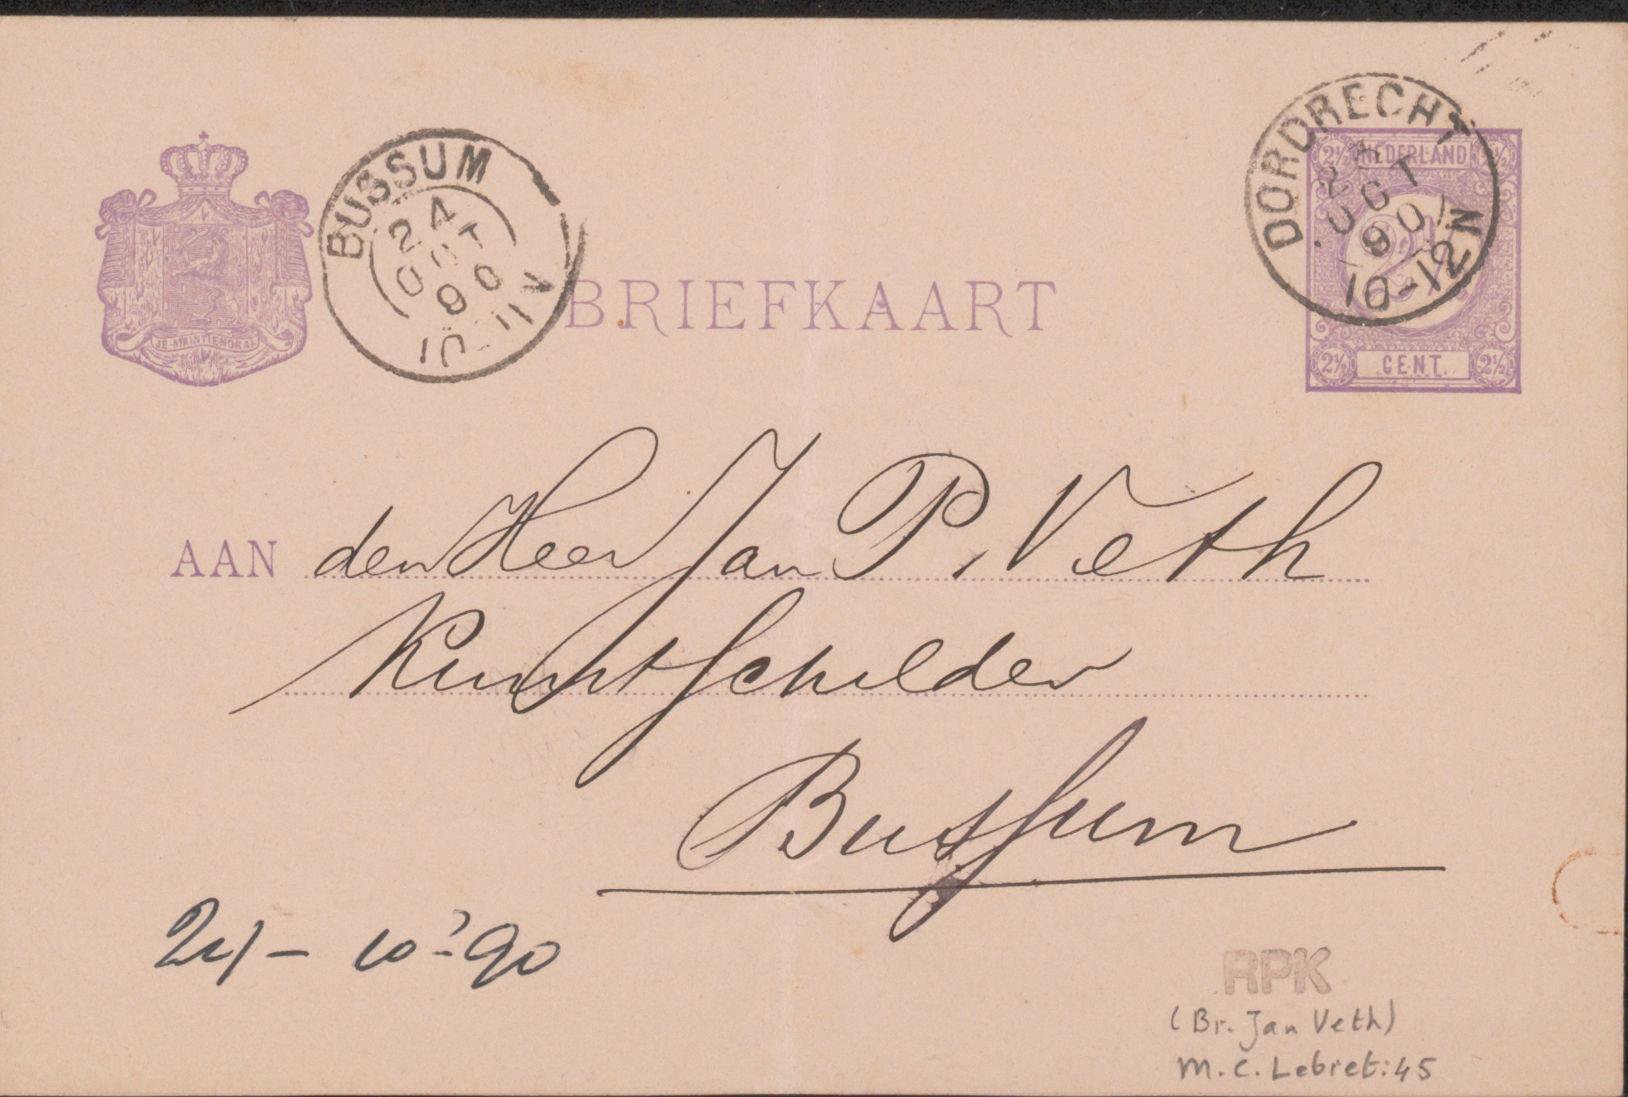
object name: postcard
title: Briefkaart aan Jan Veth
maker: martinus cornelis lebret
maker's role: verzamelaar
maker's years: 1833-1894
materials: cardboard, ink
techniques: pen, writing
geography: dordrecht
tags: dordrecht, designer, jan veth, leiden, amsterdam, painter, print maker, draughtsman, rembrandt van rijn, albrecht dürer, art trade, art shop, berlin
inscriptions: collector's mark: ‘RPK’